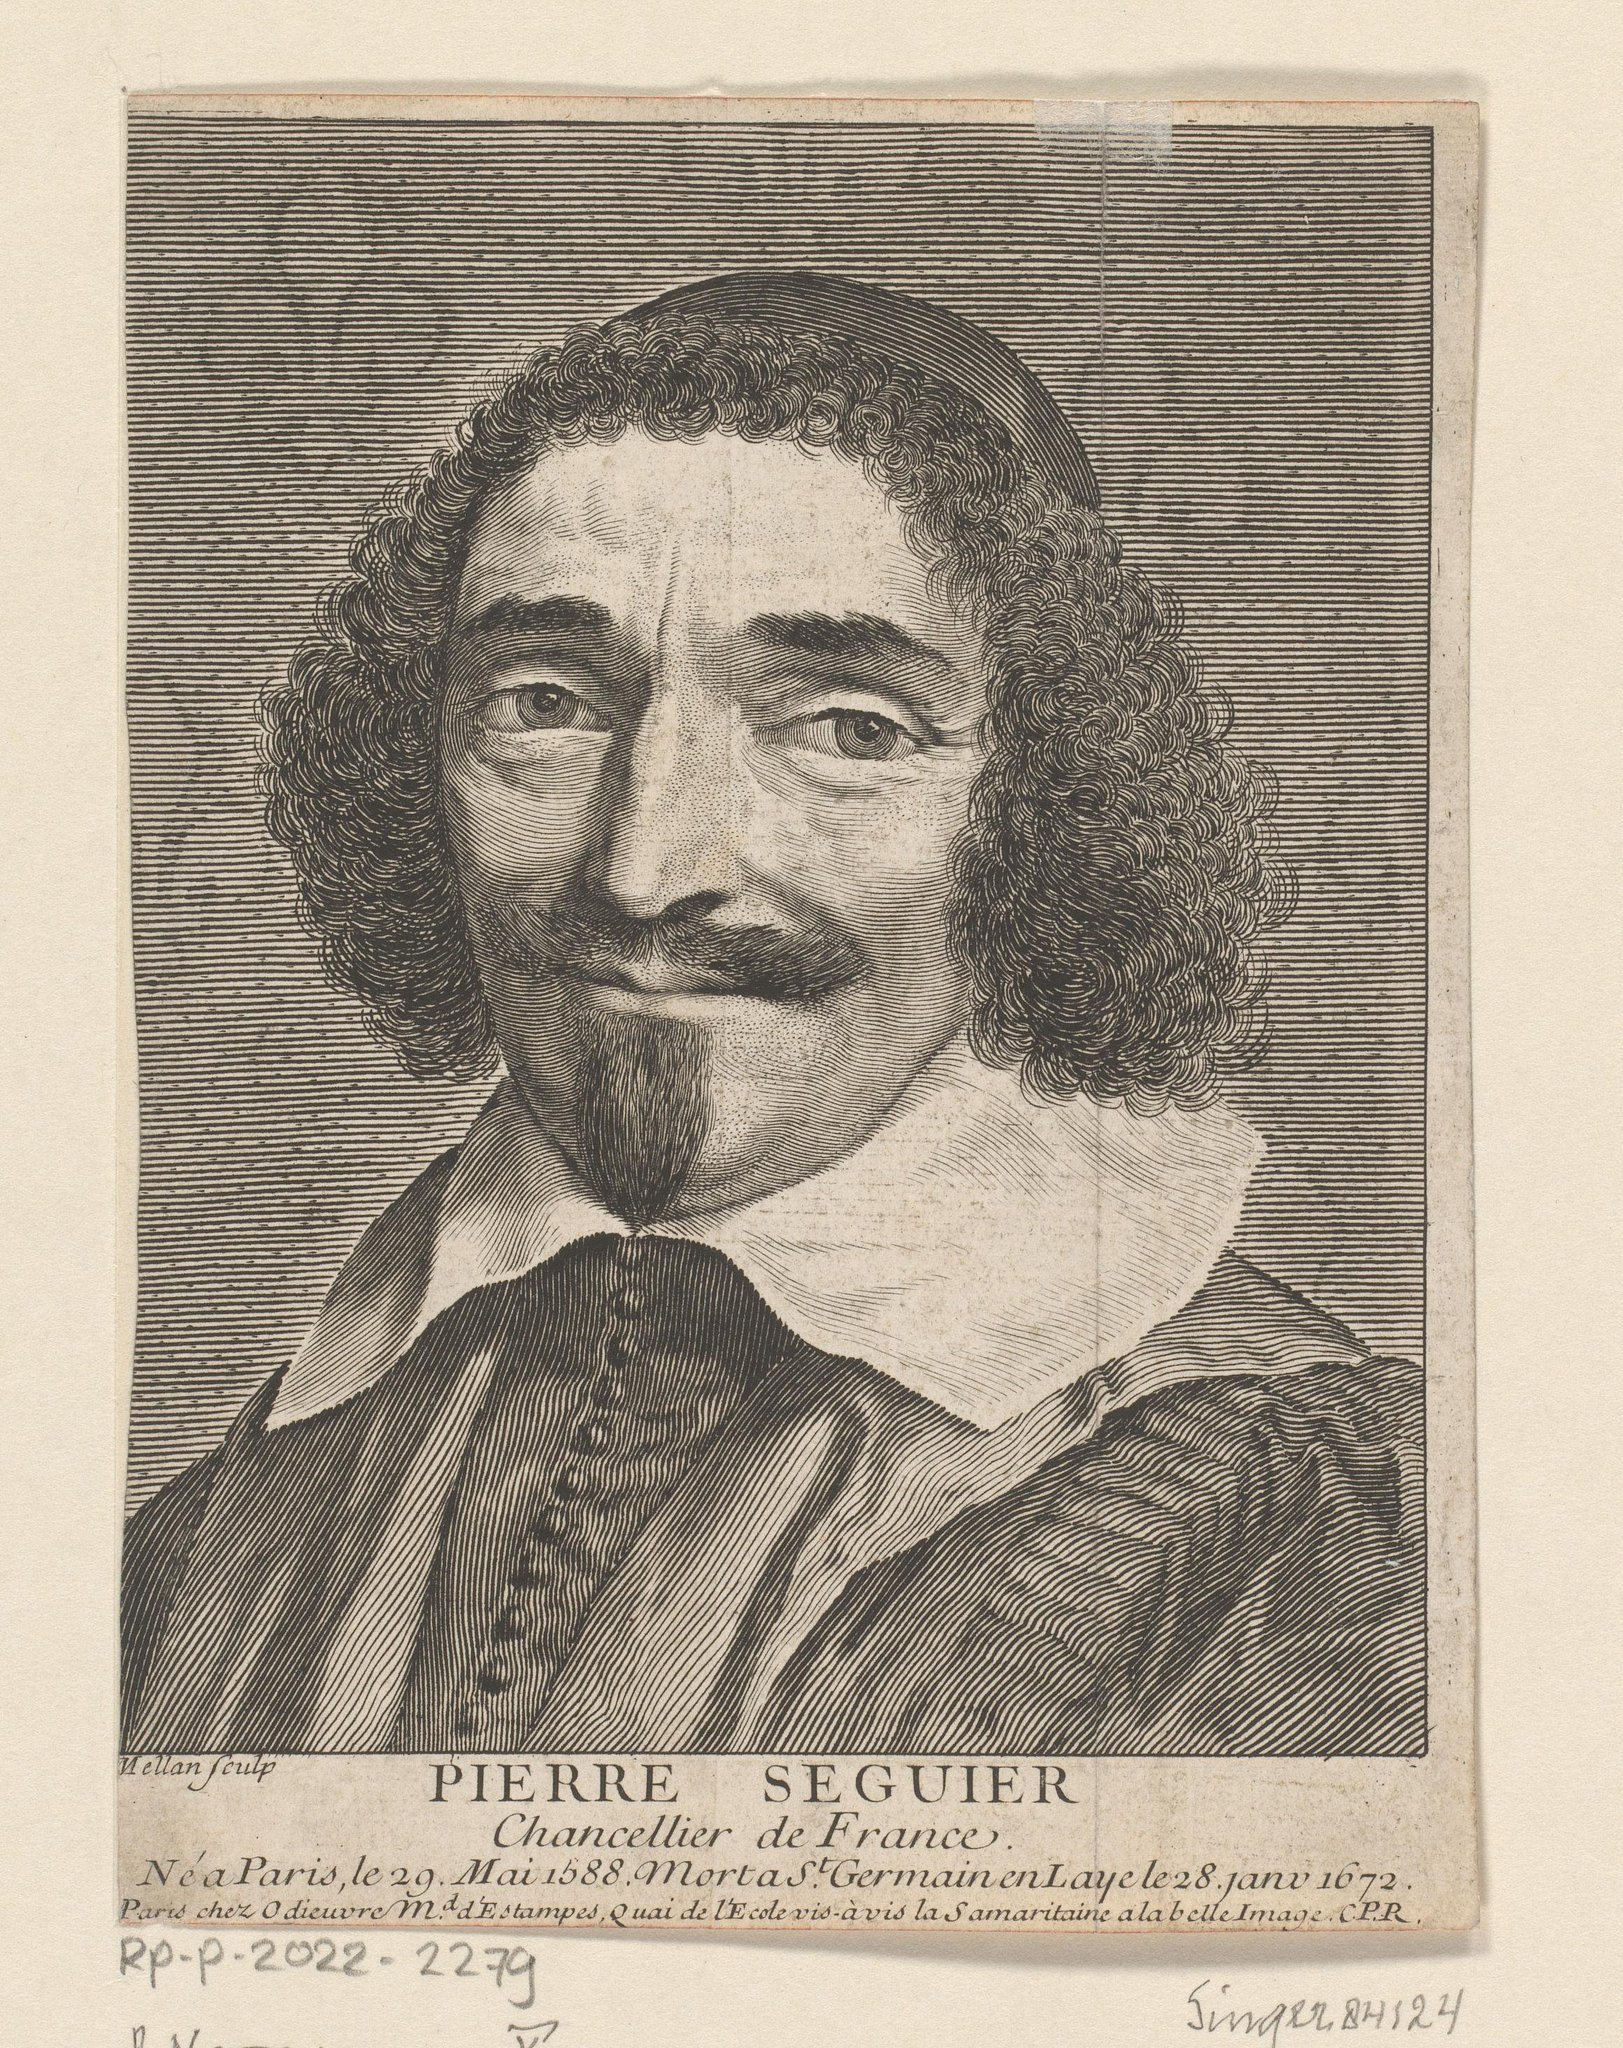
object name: print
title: Portret van Pierre Séguier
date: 1777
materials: paper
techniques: engraving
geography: paris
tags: pierre séguier, official; civil servant; functionary (in general), historical persons, politician, e.g. party leader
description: Prent waarschijnlijk uit: Dreux du Radier, Jean-François. L'Europe illustré, contenant l'histoire abregée des souverains, des princes, des prélats, des ministres, (...). Parijs: Jean-Luc Nyon, 1777, dl. 3.